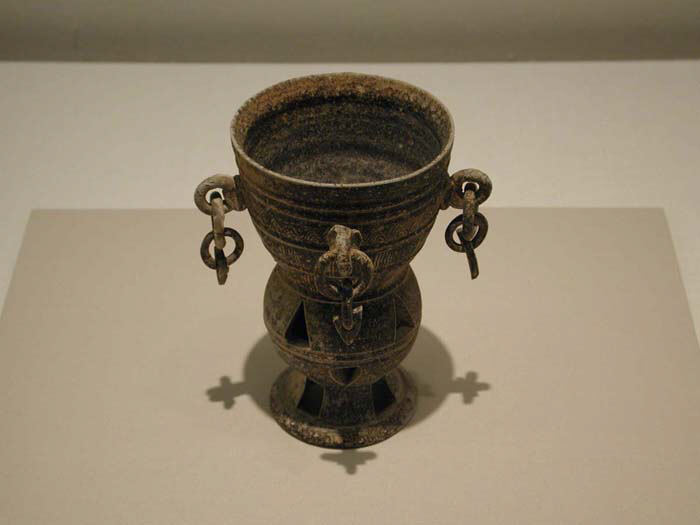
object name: cup with pendant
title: Bell Cup with Pendants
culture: korean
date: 401-600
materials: wood, glaze, stoneware